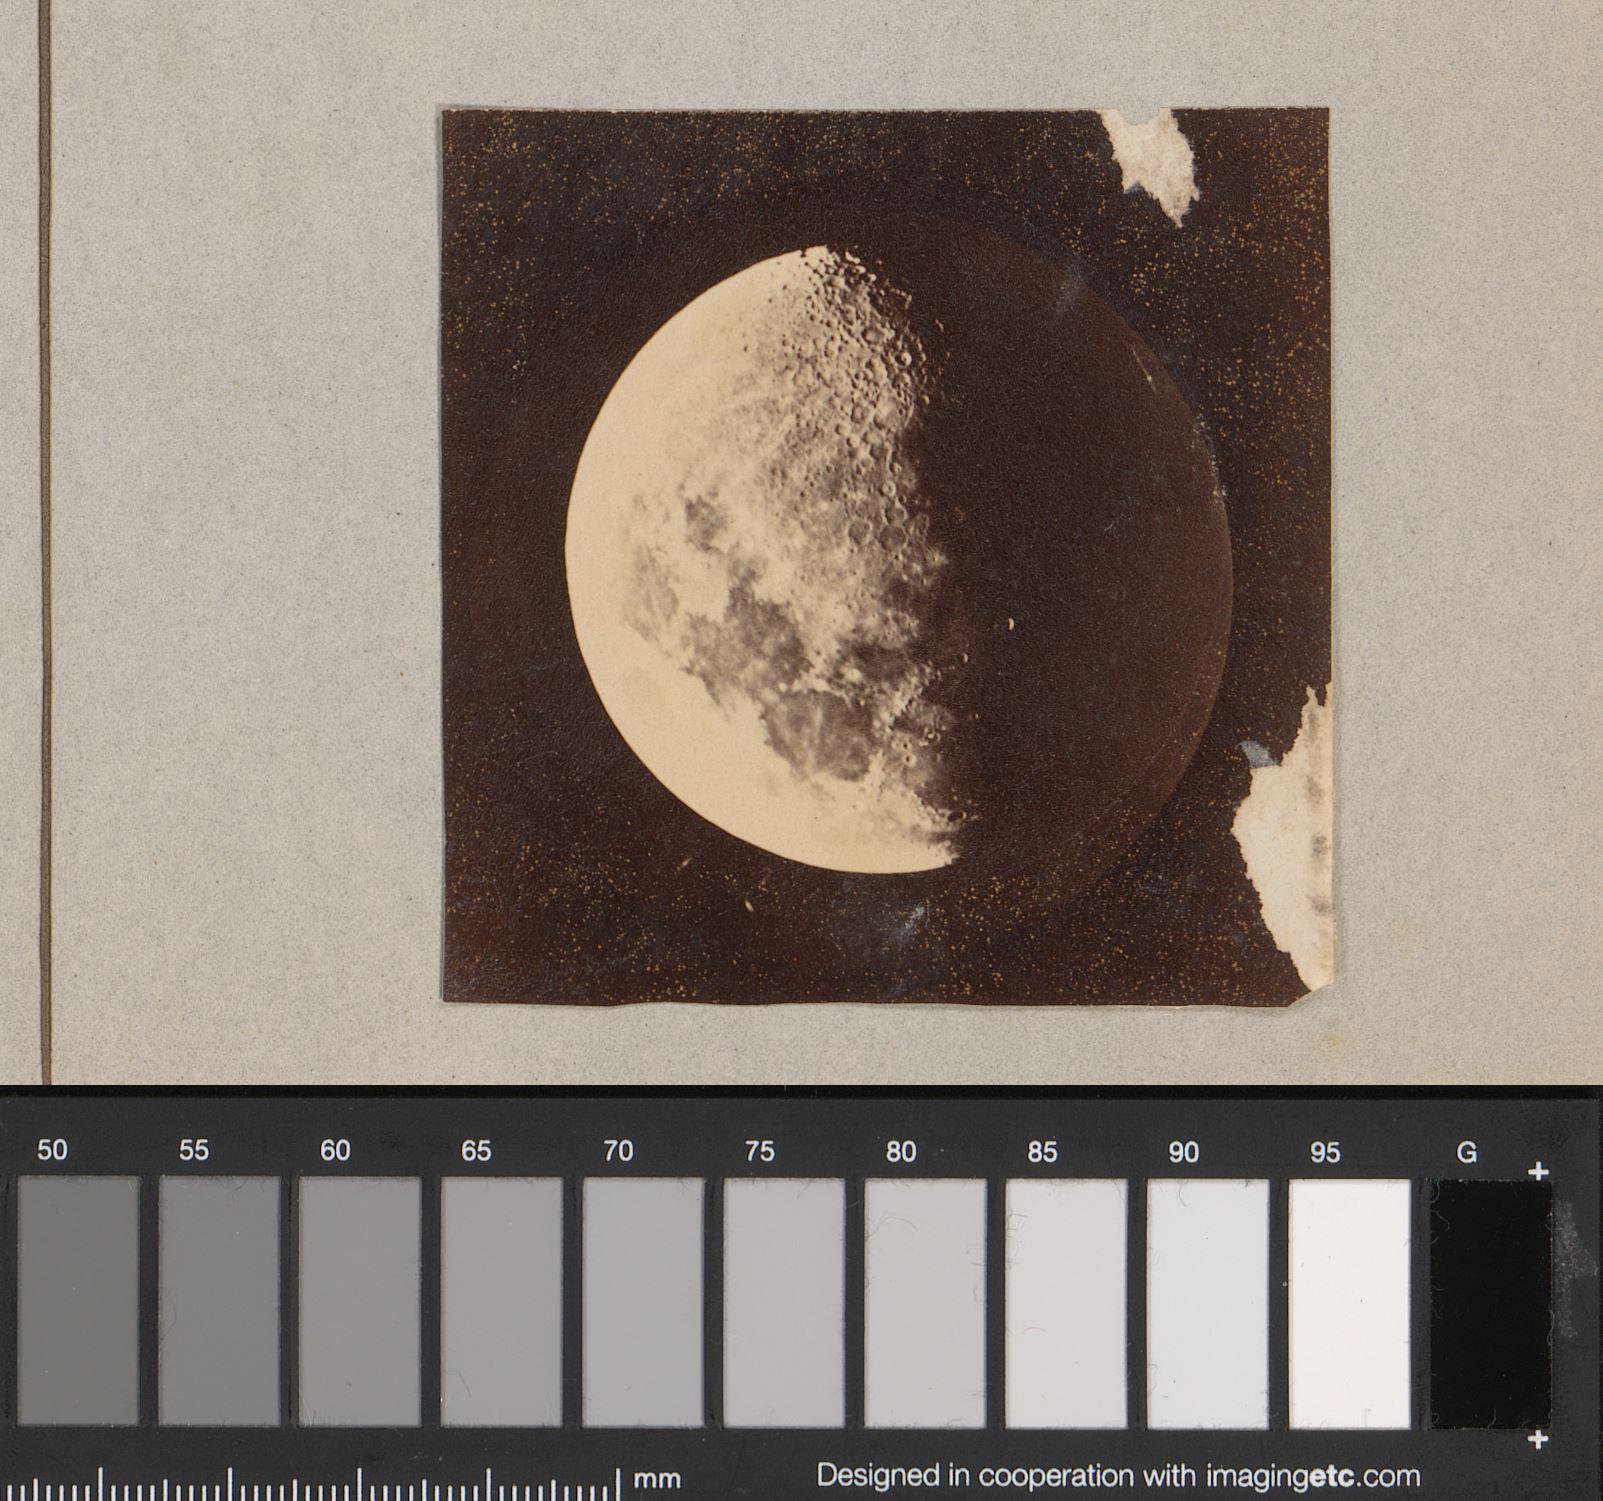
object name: reproduction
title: Fotoreproductie van foto door Warren de la Rue van vlekken op de maan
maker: marinus pieter filbri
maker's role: instrument maker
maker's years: 1852-1917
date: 1887-1888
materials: paper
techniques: albumen print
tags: surface of the moon, moon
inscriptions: inscription: ‘Vlekken op de maan/ naar phot.’